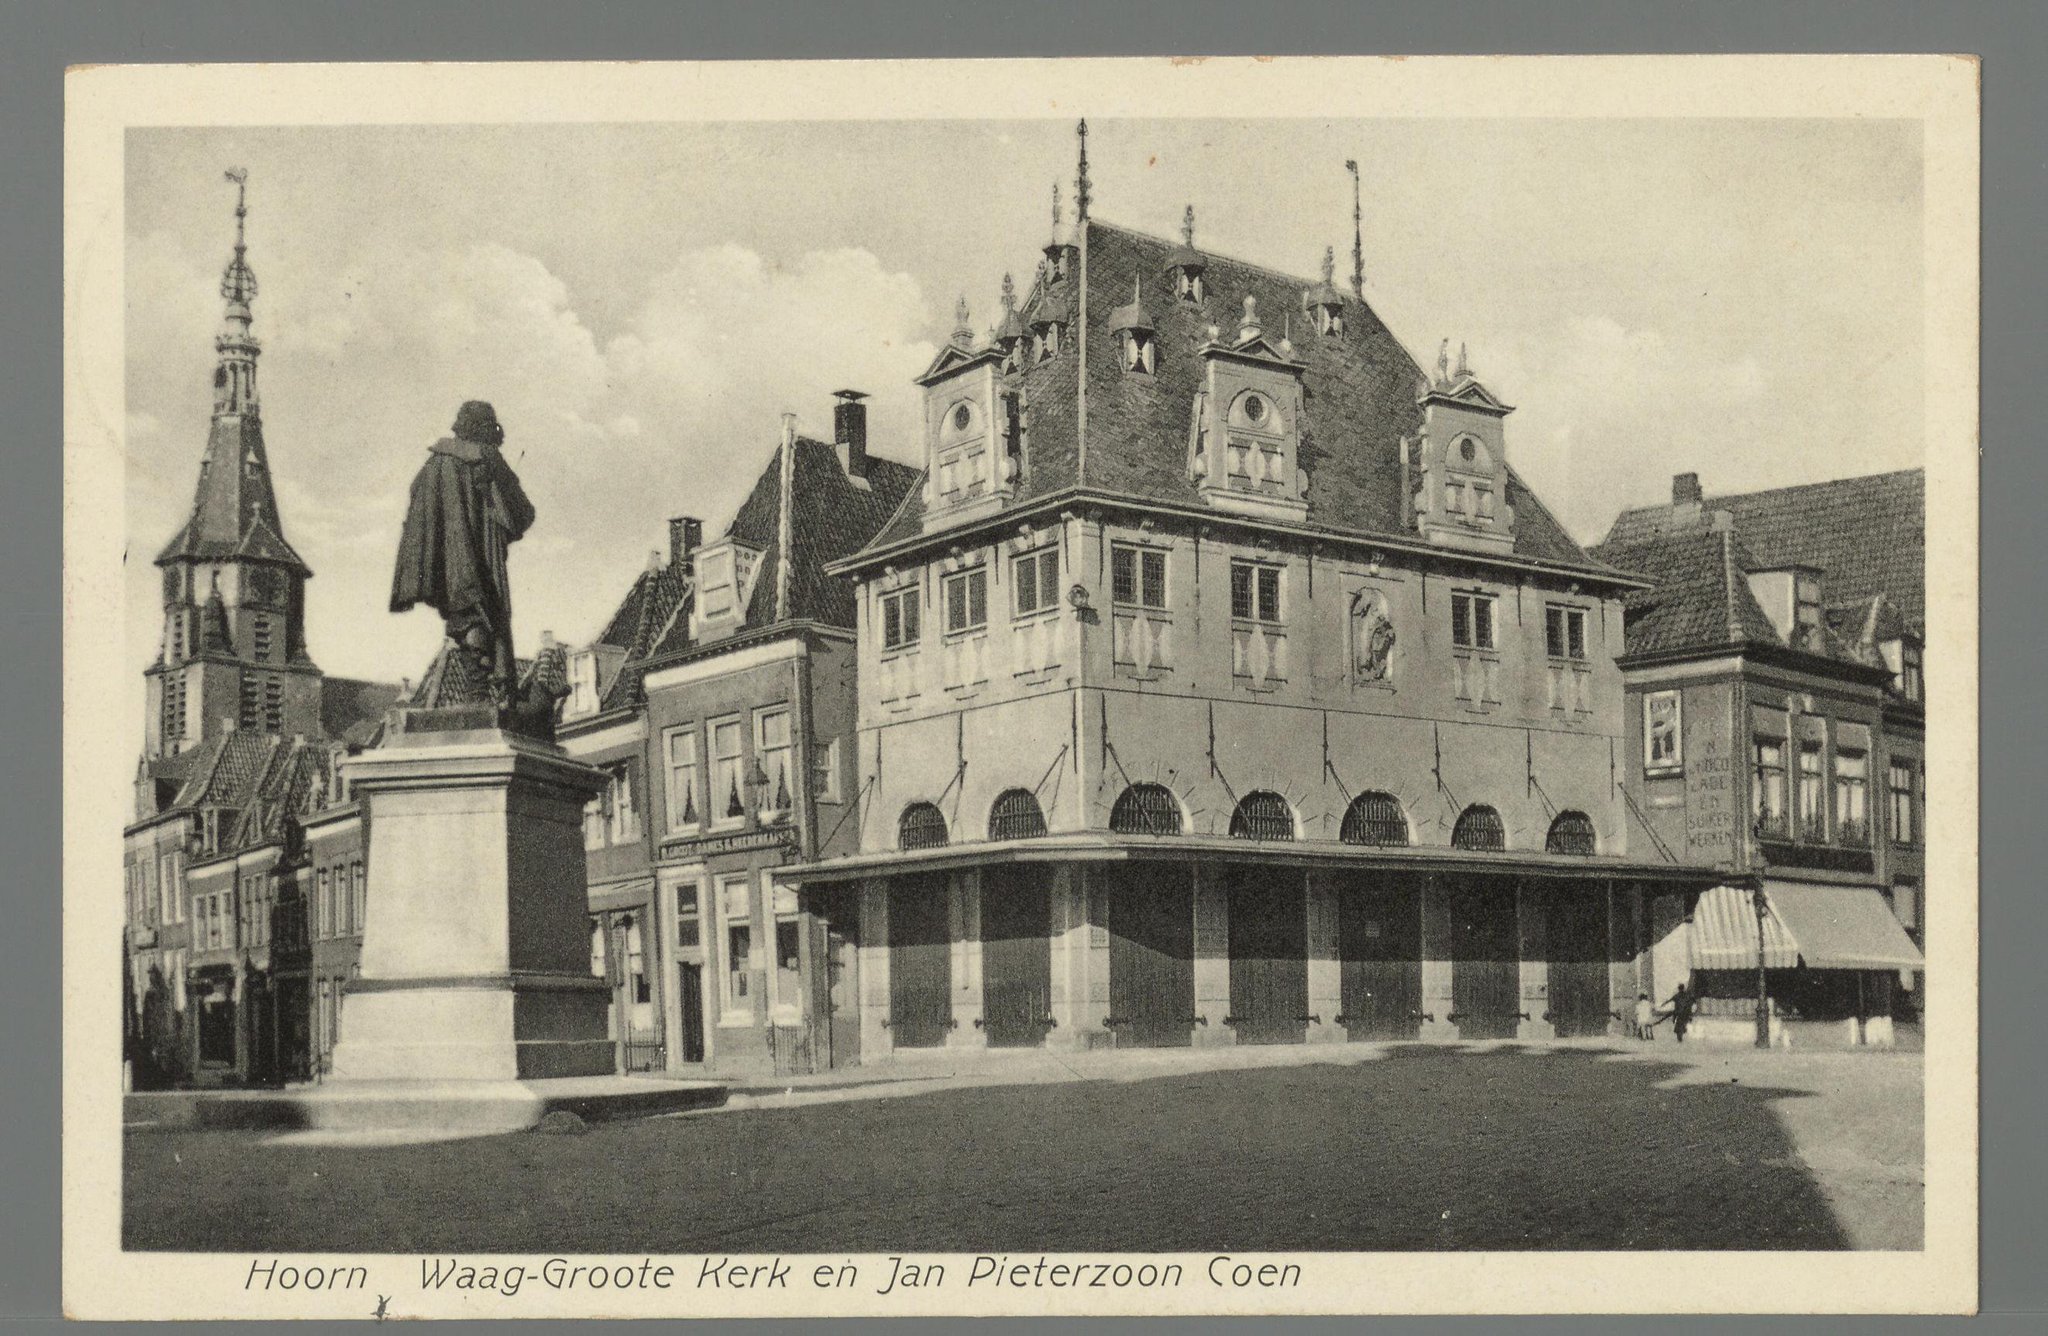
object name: ansichtkaart, prentbriefkaart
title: Hoorn Waag-Groote Kerk en Jan Pieterzoon Coen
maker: Anonymous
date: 1929-1933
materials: cardboard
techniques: photograph, writing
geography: hoorn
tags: city-view, and landscape with man-made constructions, sculpture, hoorn (north holland)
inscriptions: postage stamp